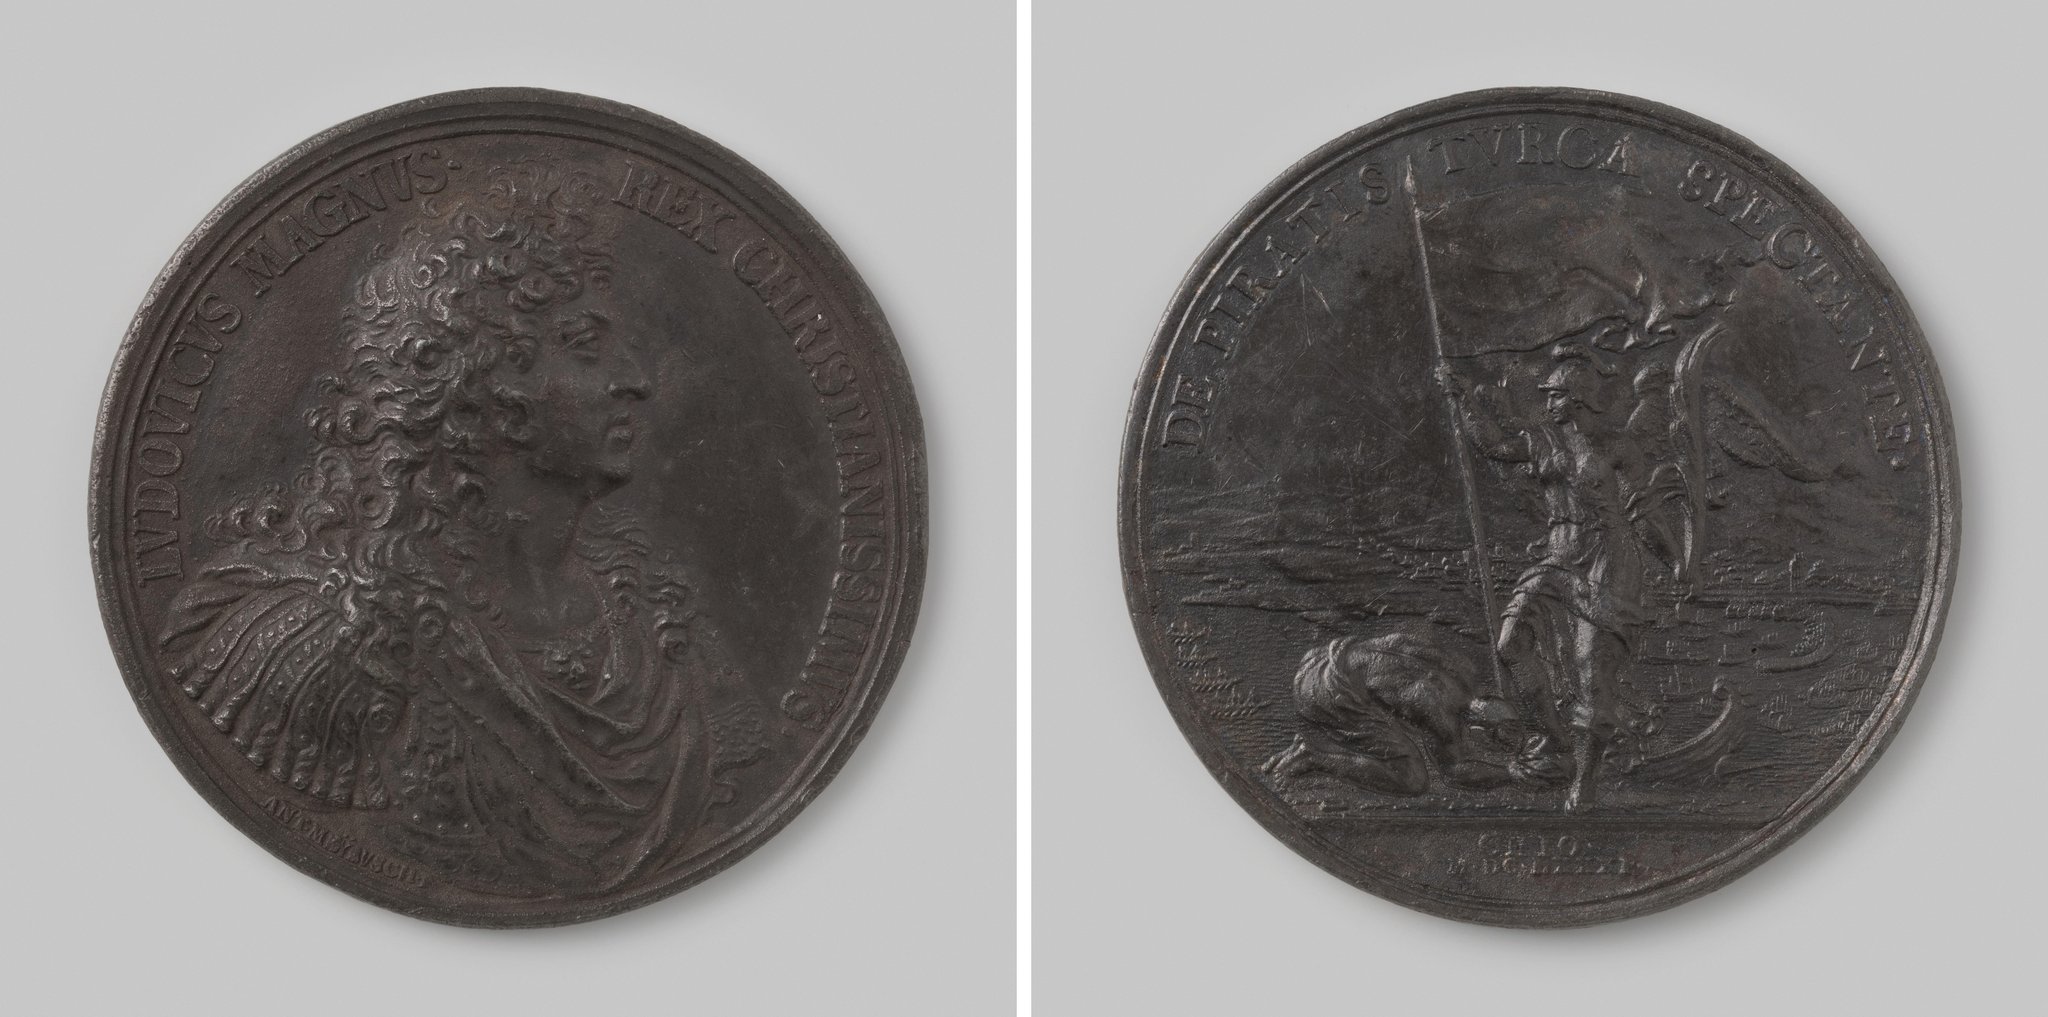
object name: history medal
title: Tuchtiging van de zeerovers in de haven Chio door Koning Lodewijk XIV van Frankrijk 1681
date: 1681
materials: tin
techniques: casting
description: Forse gegoten tinnen penning, op de voorzijde het borstbeeld van Lodweijk XIV naar rechts met omschrift, op de keerzijde een verslagen man aan de voeten van Victoria, met vaandel en palmtak, op de achtergrond de haven van Chio, met omschrift en afsnedetekst.